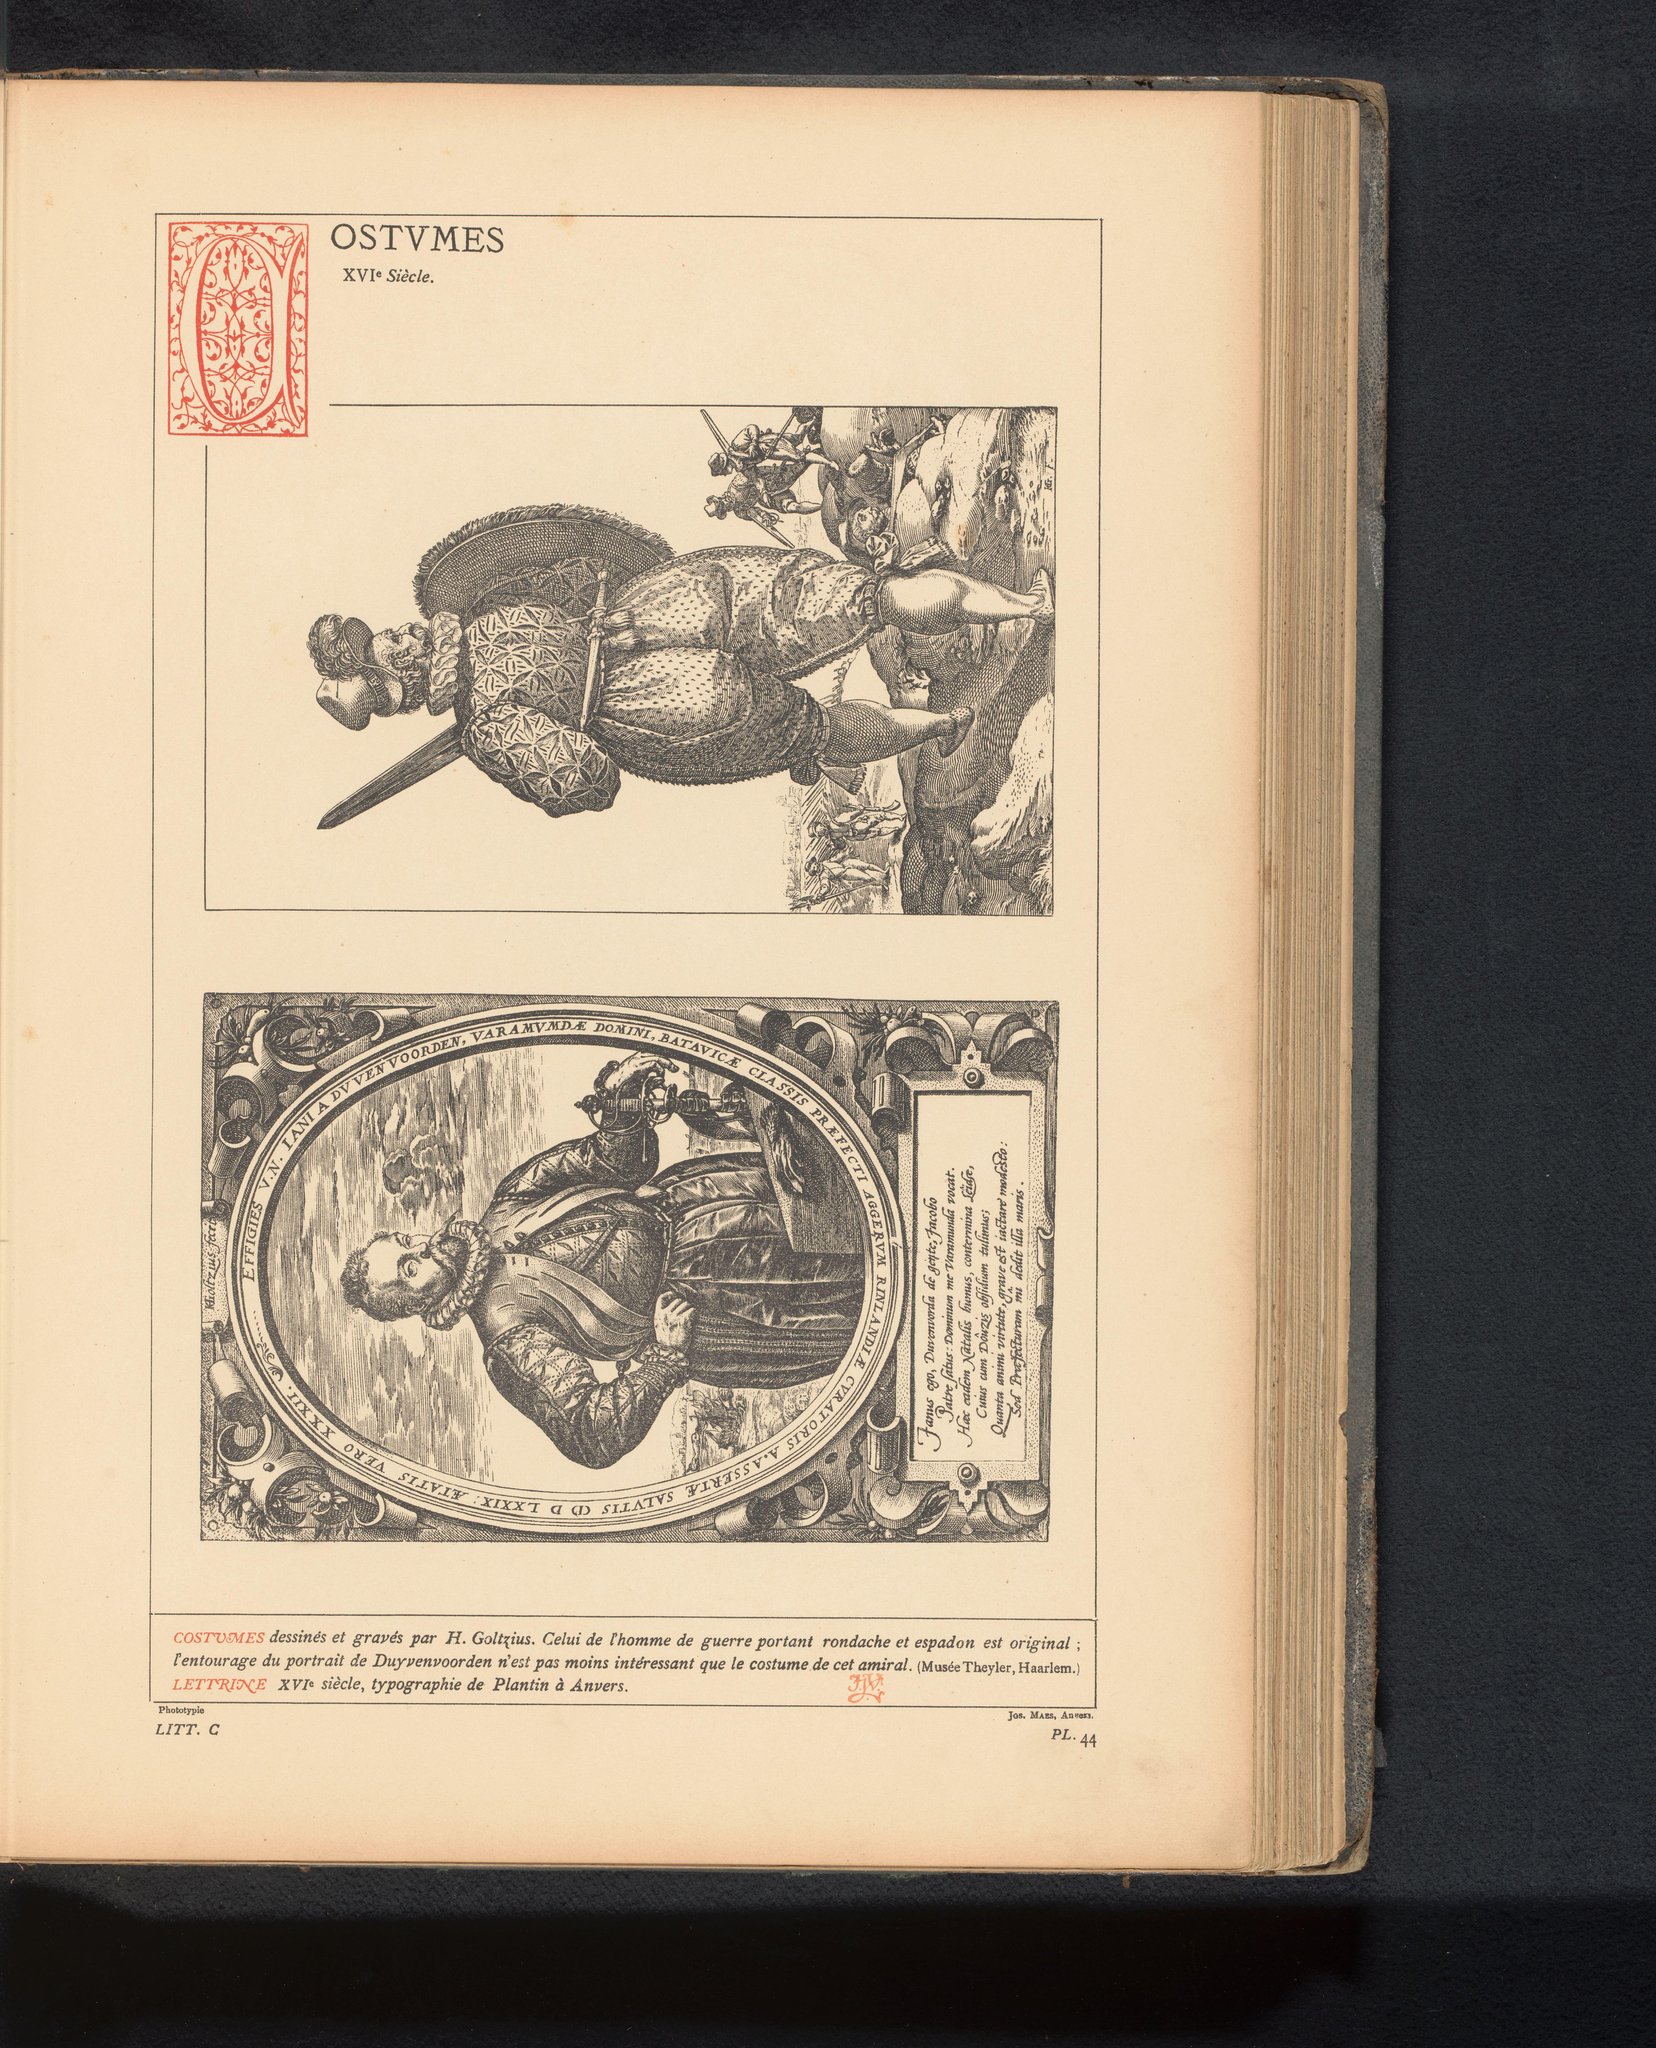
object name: photomechanical print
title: Costumes, XVIIe Siècle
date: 1875-1880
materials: paper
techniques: photolithography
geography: antwerp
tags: the hague, historical persons, clothes, costume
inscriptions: monogram: ‘JJvY’, inscription: ‘LITT: C. - PL. 44’, inscription: ‘Costumes dessinés et (...)’